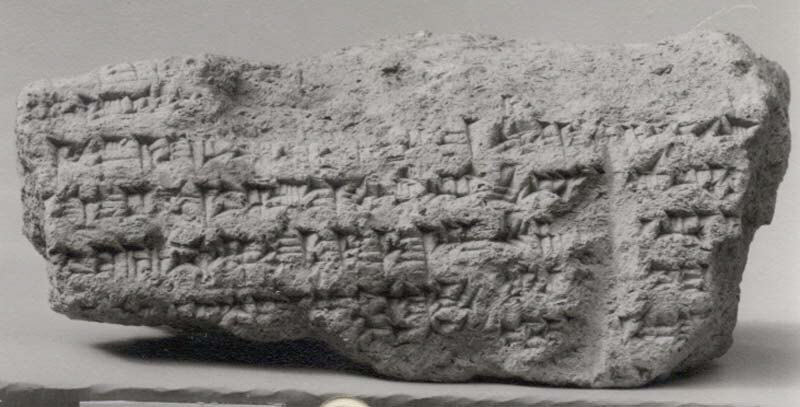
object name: cuneiform cylinder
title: Cuneiform cylinder: inscription of Nebuchadnezzar II describing work done on a wall and moat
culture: babylonian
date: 604-562 BCE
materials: clay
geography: mesopotamia